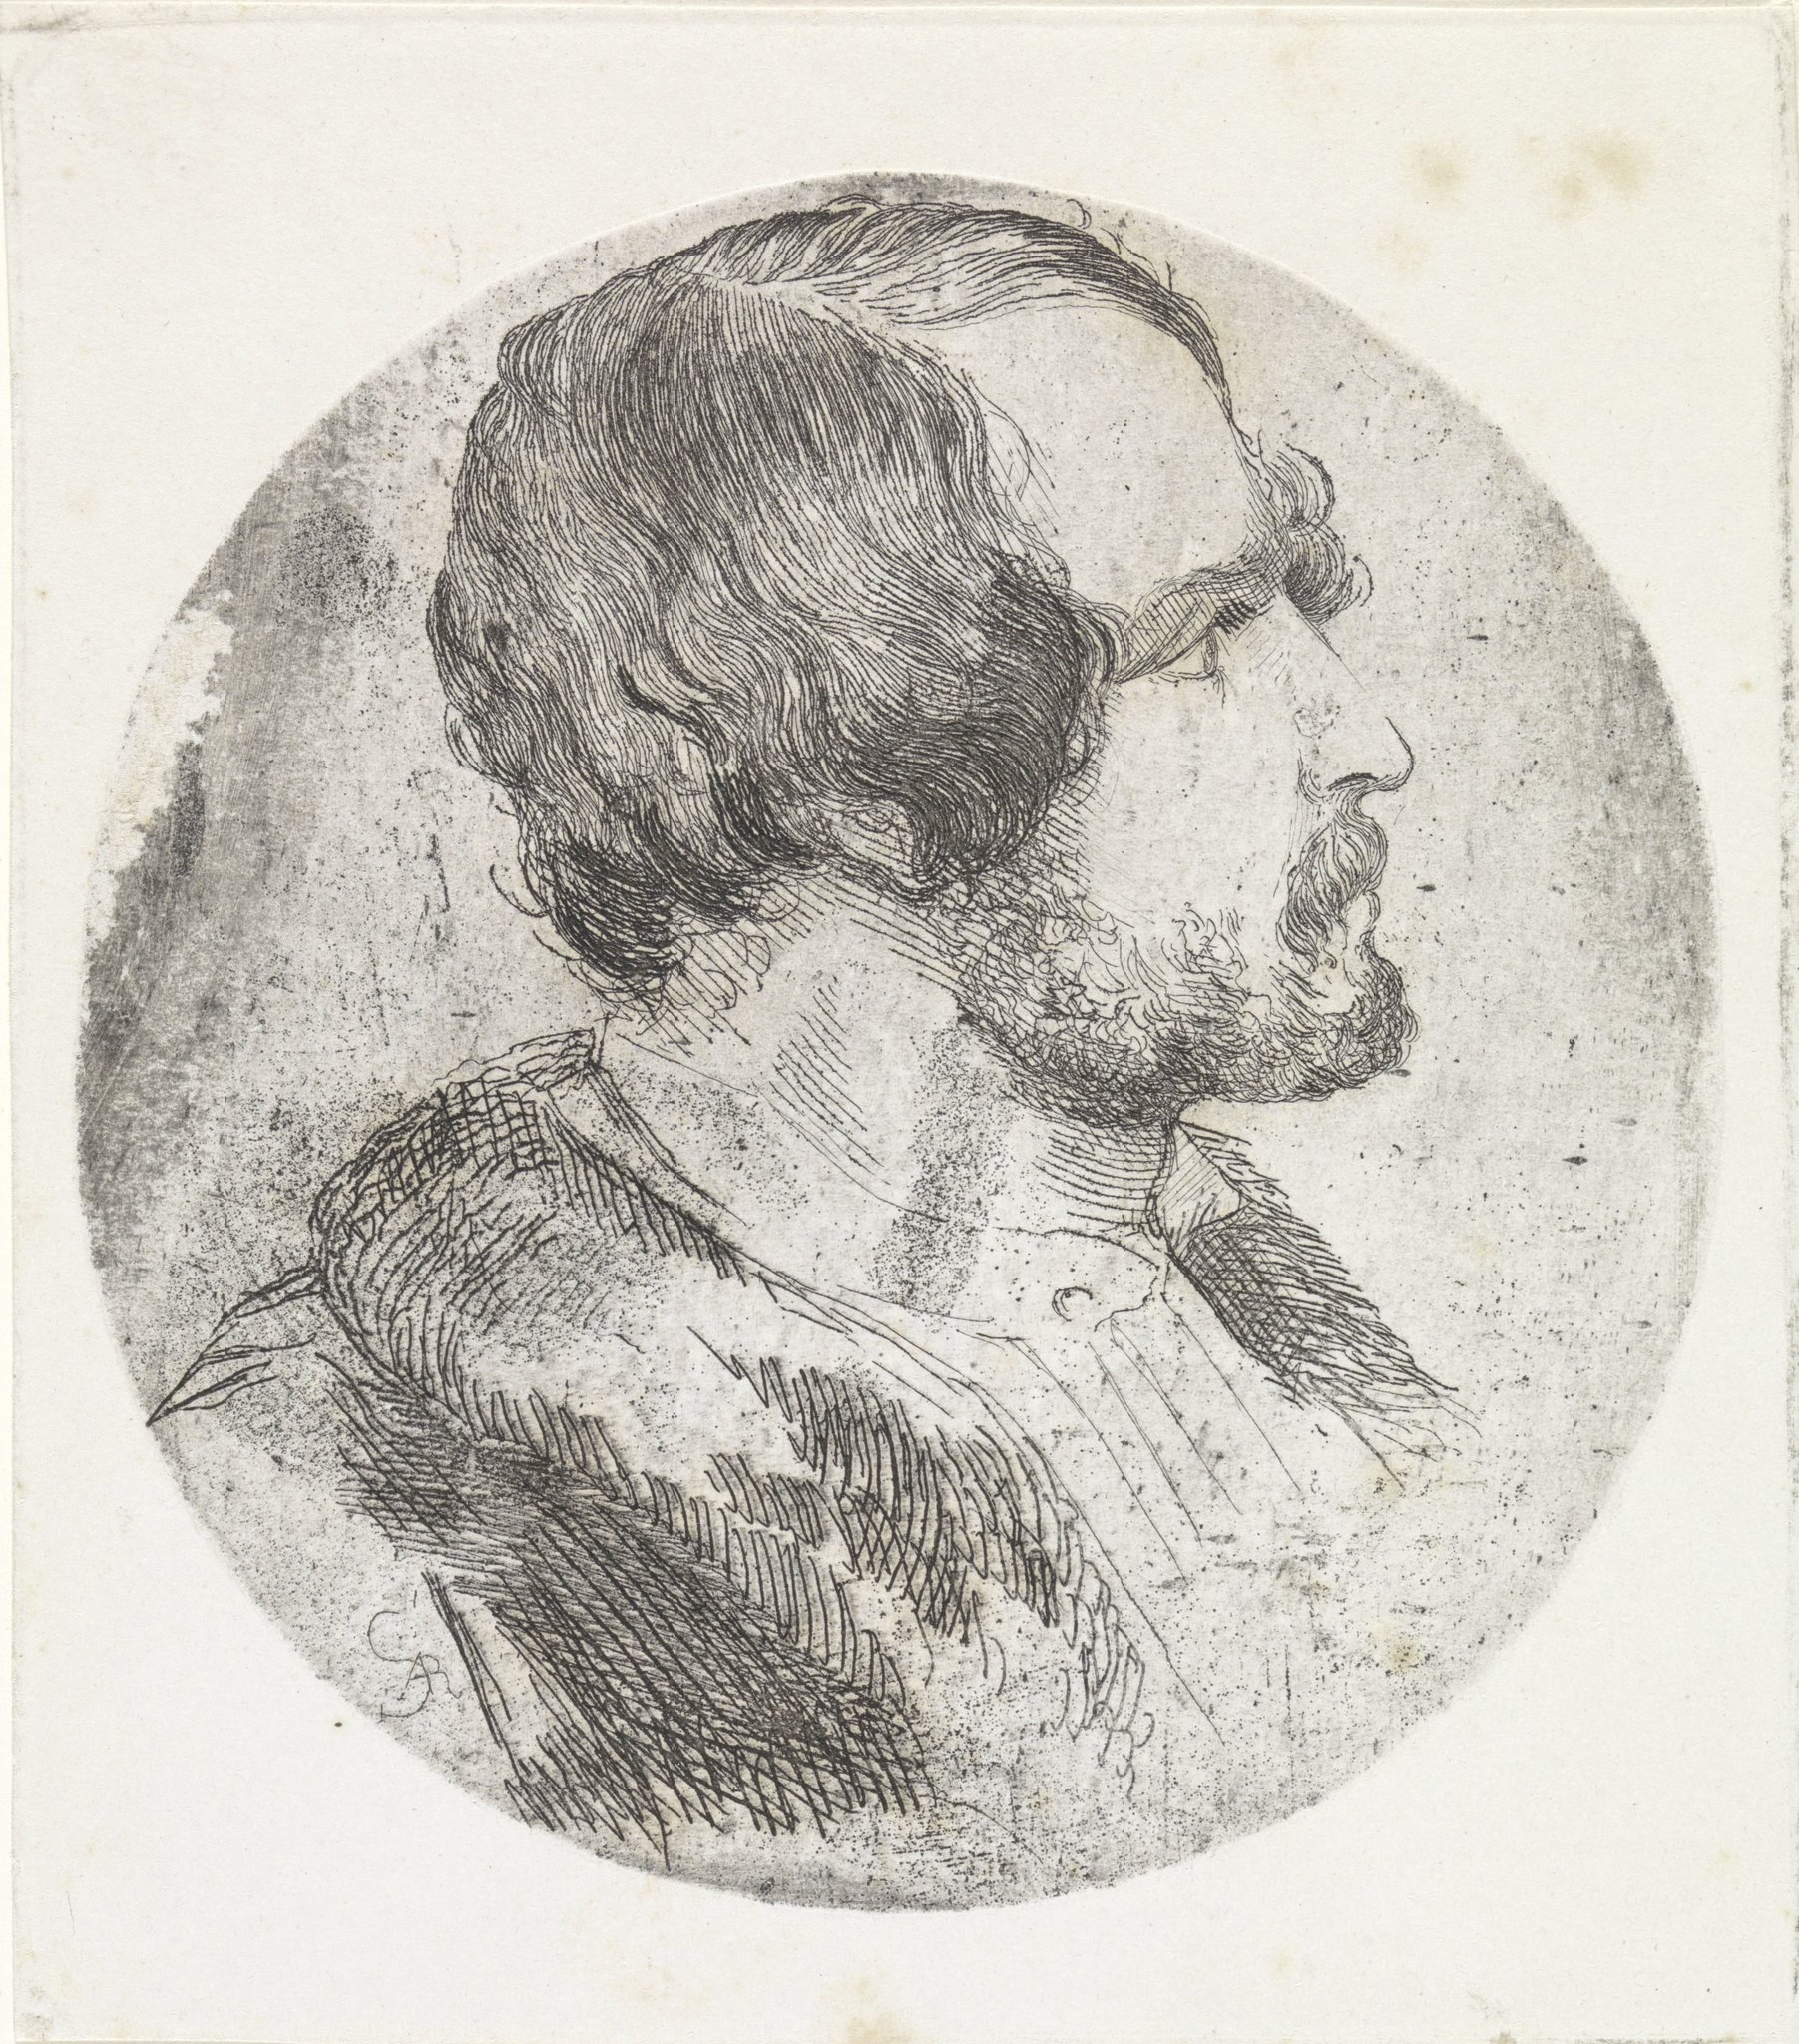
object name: print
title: Portret van prentmaker Alexander Schaepkens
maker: arnoud schaepkens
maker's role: print maker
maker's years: 1816-1904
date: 1831-1904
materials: paper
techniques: etching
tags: maastricht, draughtsman, alexander schaepkens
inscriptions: collector's mark: Lugt 2228